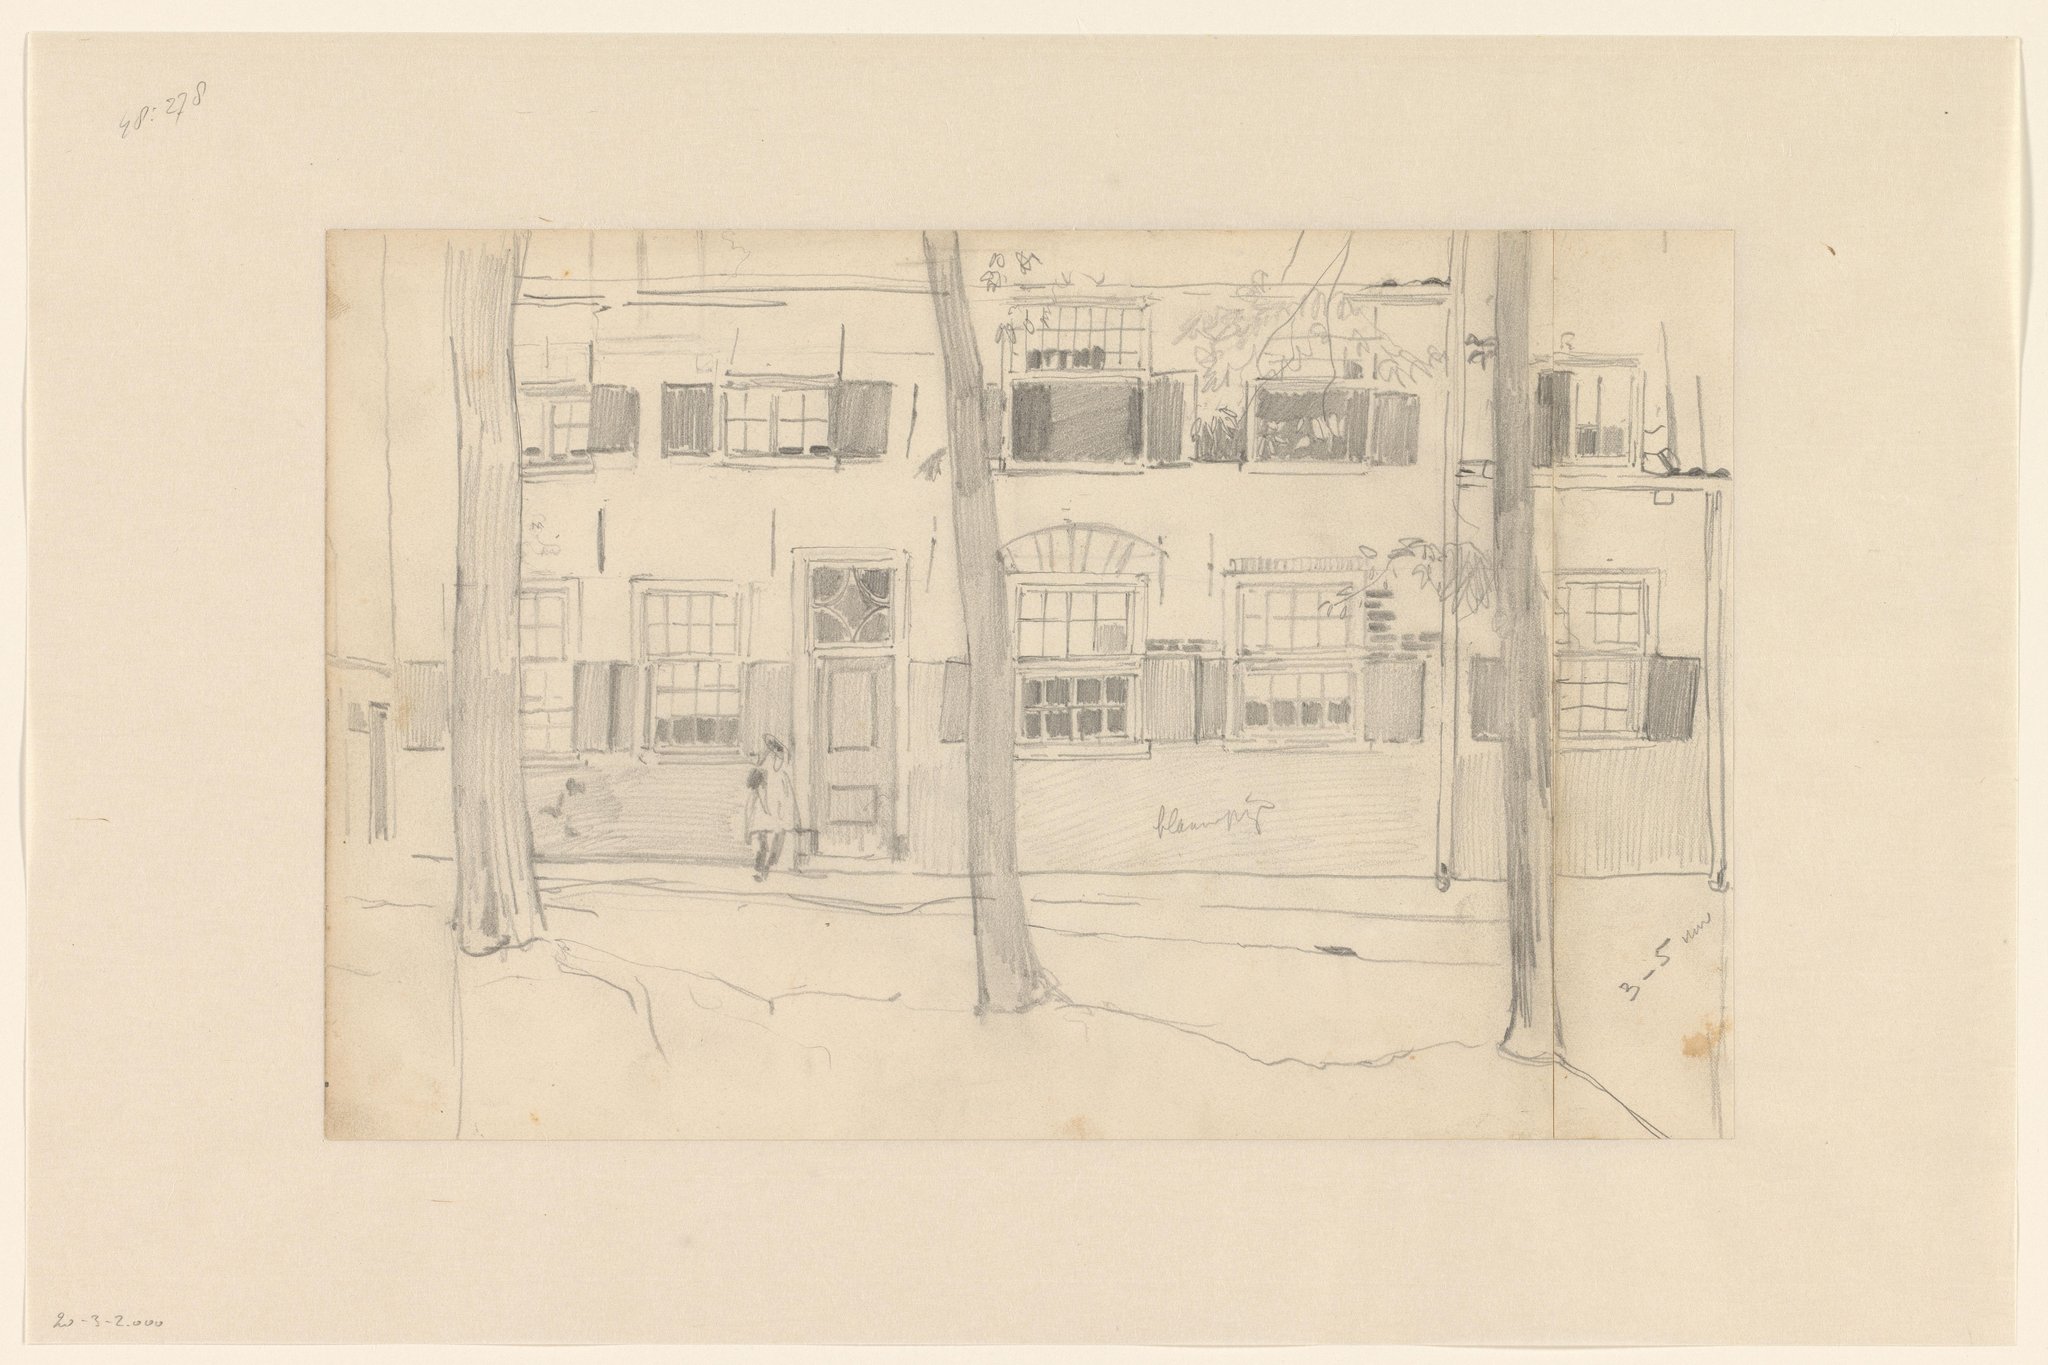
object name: drawing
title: Huizen aan een straat, met kleurnotities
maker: floris verster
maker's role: draughtsman, painter, print maker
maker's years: 1861-1927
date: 1871-1927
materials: paper, pencil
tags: street